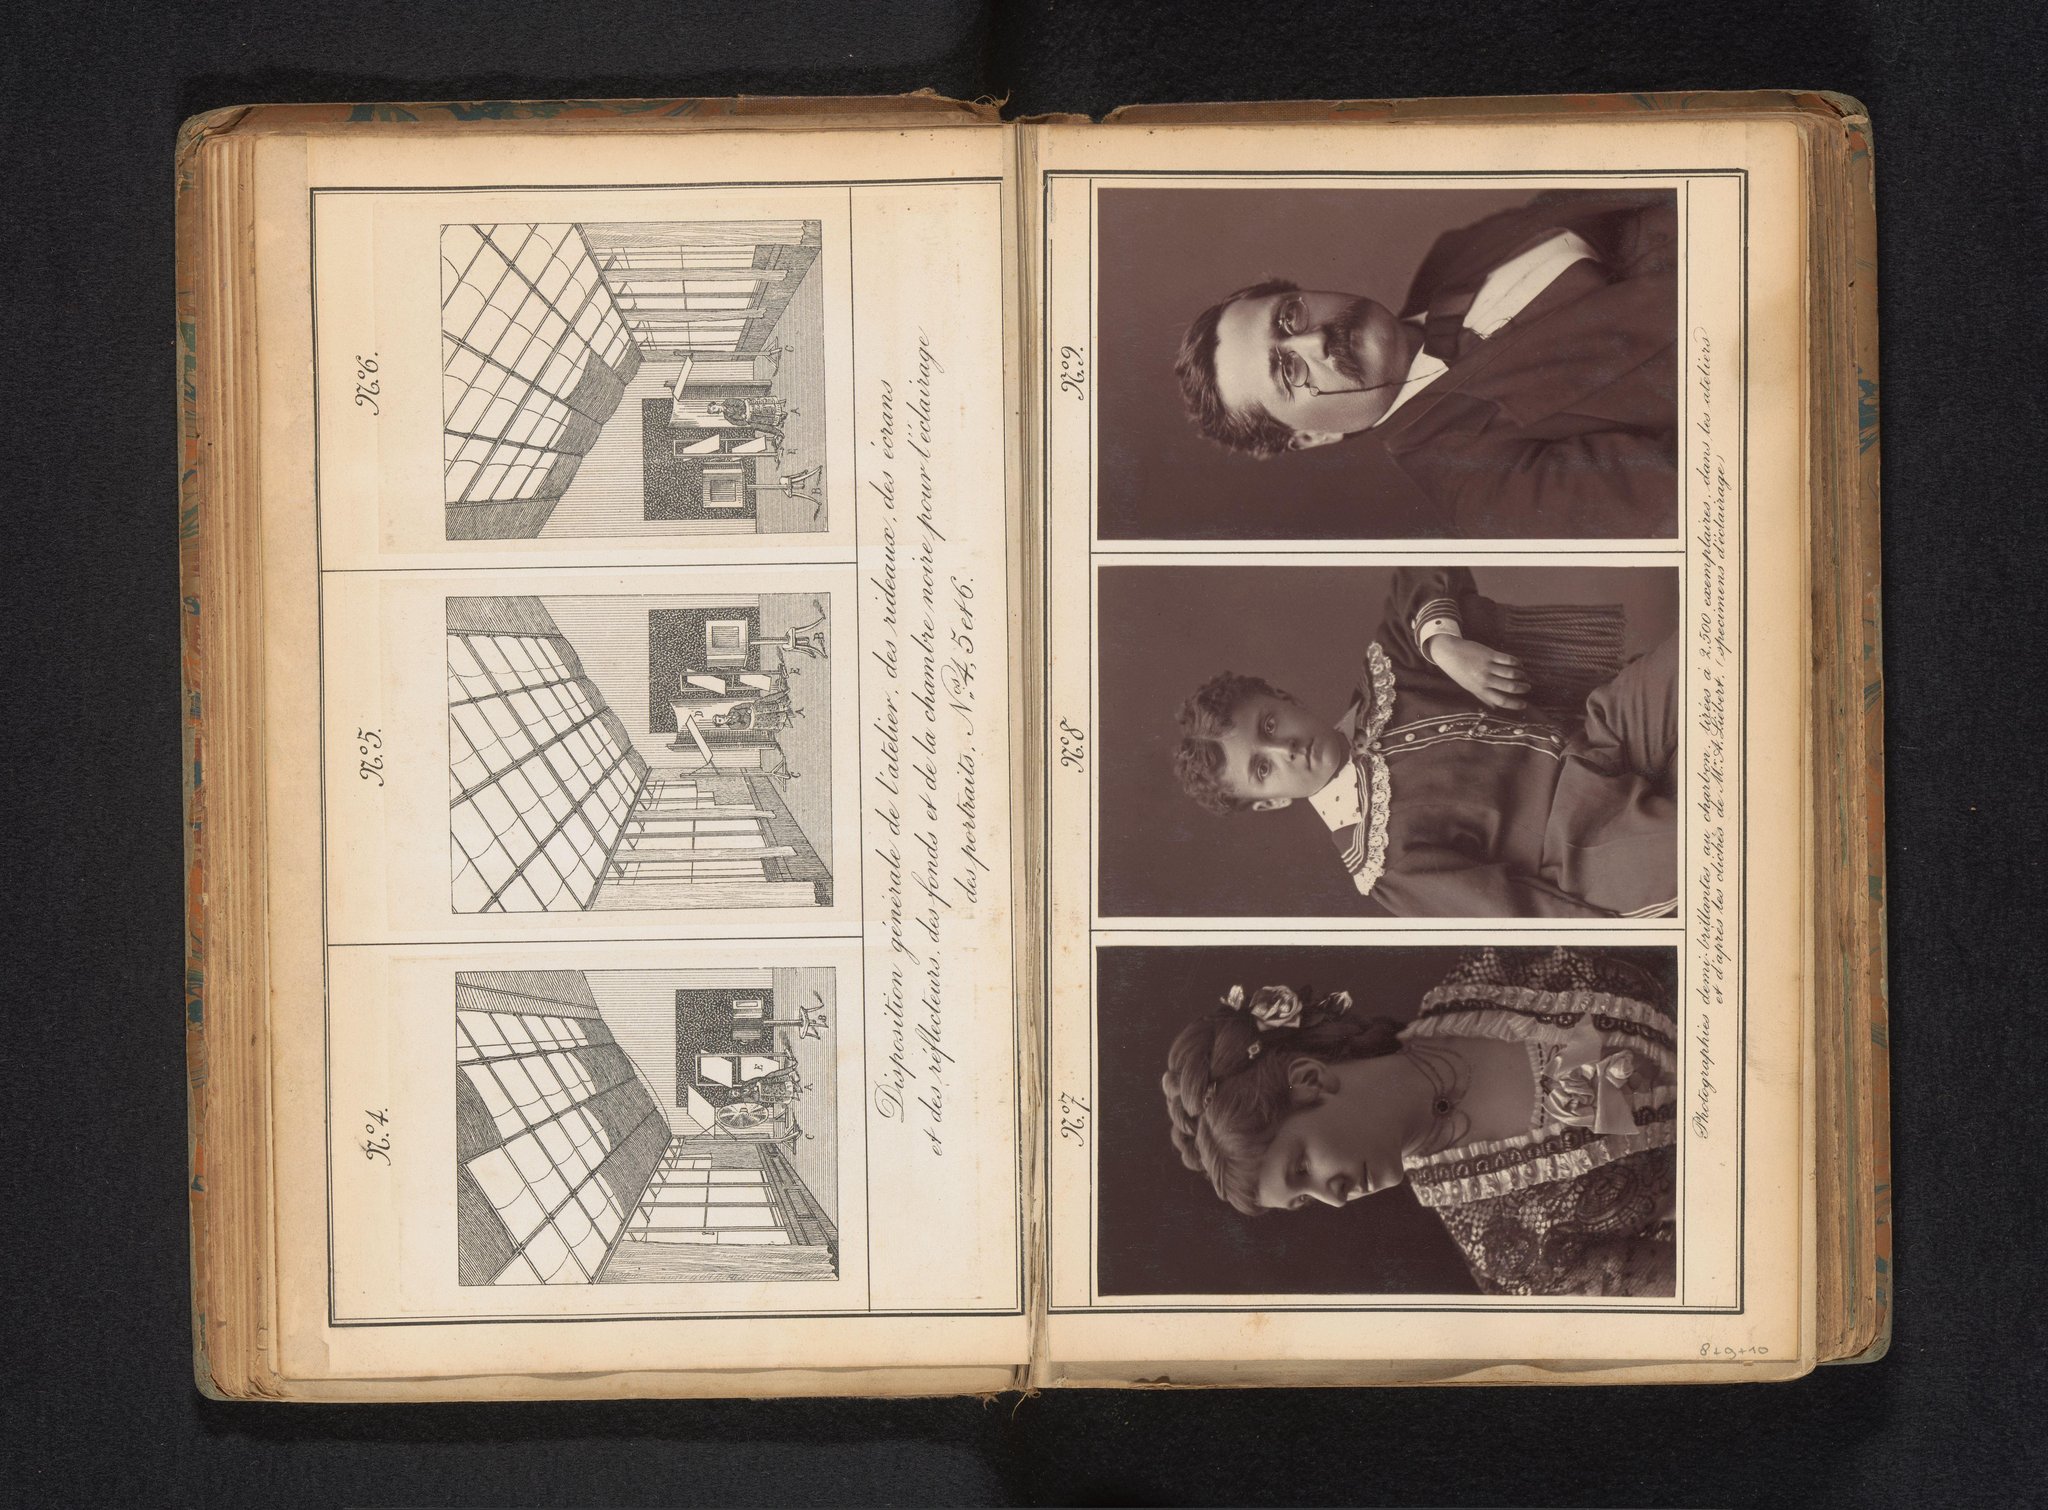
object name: page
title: Belichtingsstudie, afgebeeld een portret van een onbekende vrouw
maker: alphonse-justin liébert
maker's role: fotograaf, marinier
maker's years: 1827-1914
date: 1873-1878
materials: paper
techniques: carbon print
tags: historical persons not known by name - bb - woman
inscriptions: number: ‘No. 7.’, inscription: ‘Photographies demi-brillantes au charbon, tirées à 2.500 exemplaires, dans les ateliers/ et d'après les clichés de Mr. A. Liébert. (specimens d'éclairage)’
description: Foto op vijfde ongenummerde pagina na pagina 80.